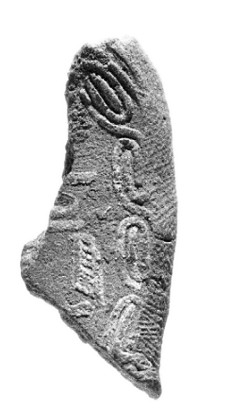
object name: sealing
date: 1981-1640 BCE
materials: mud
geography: egypt